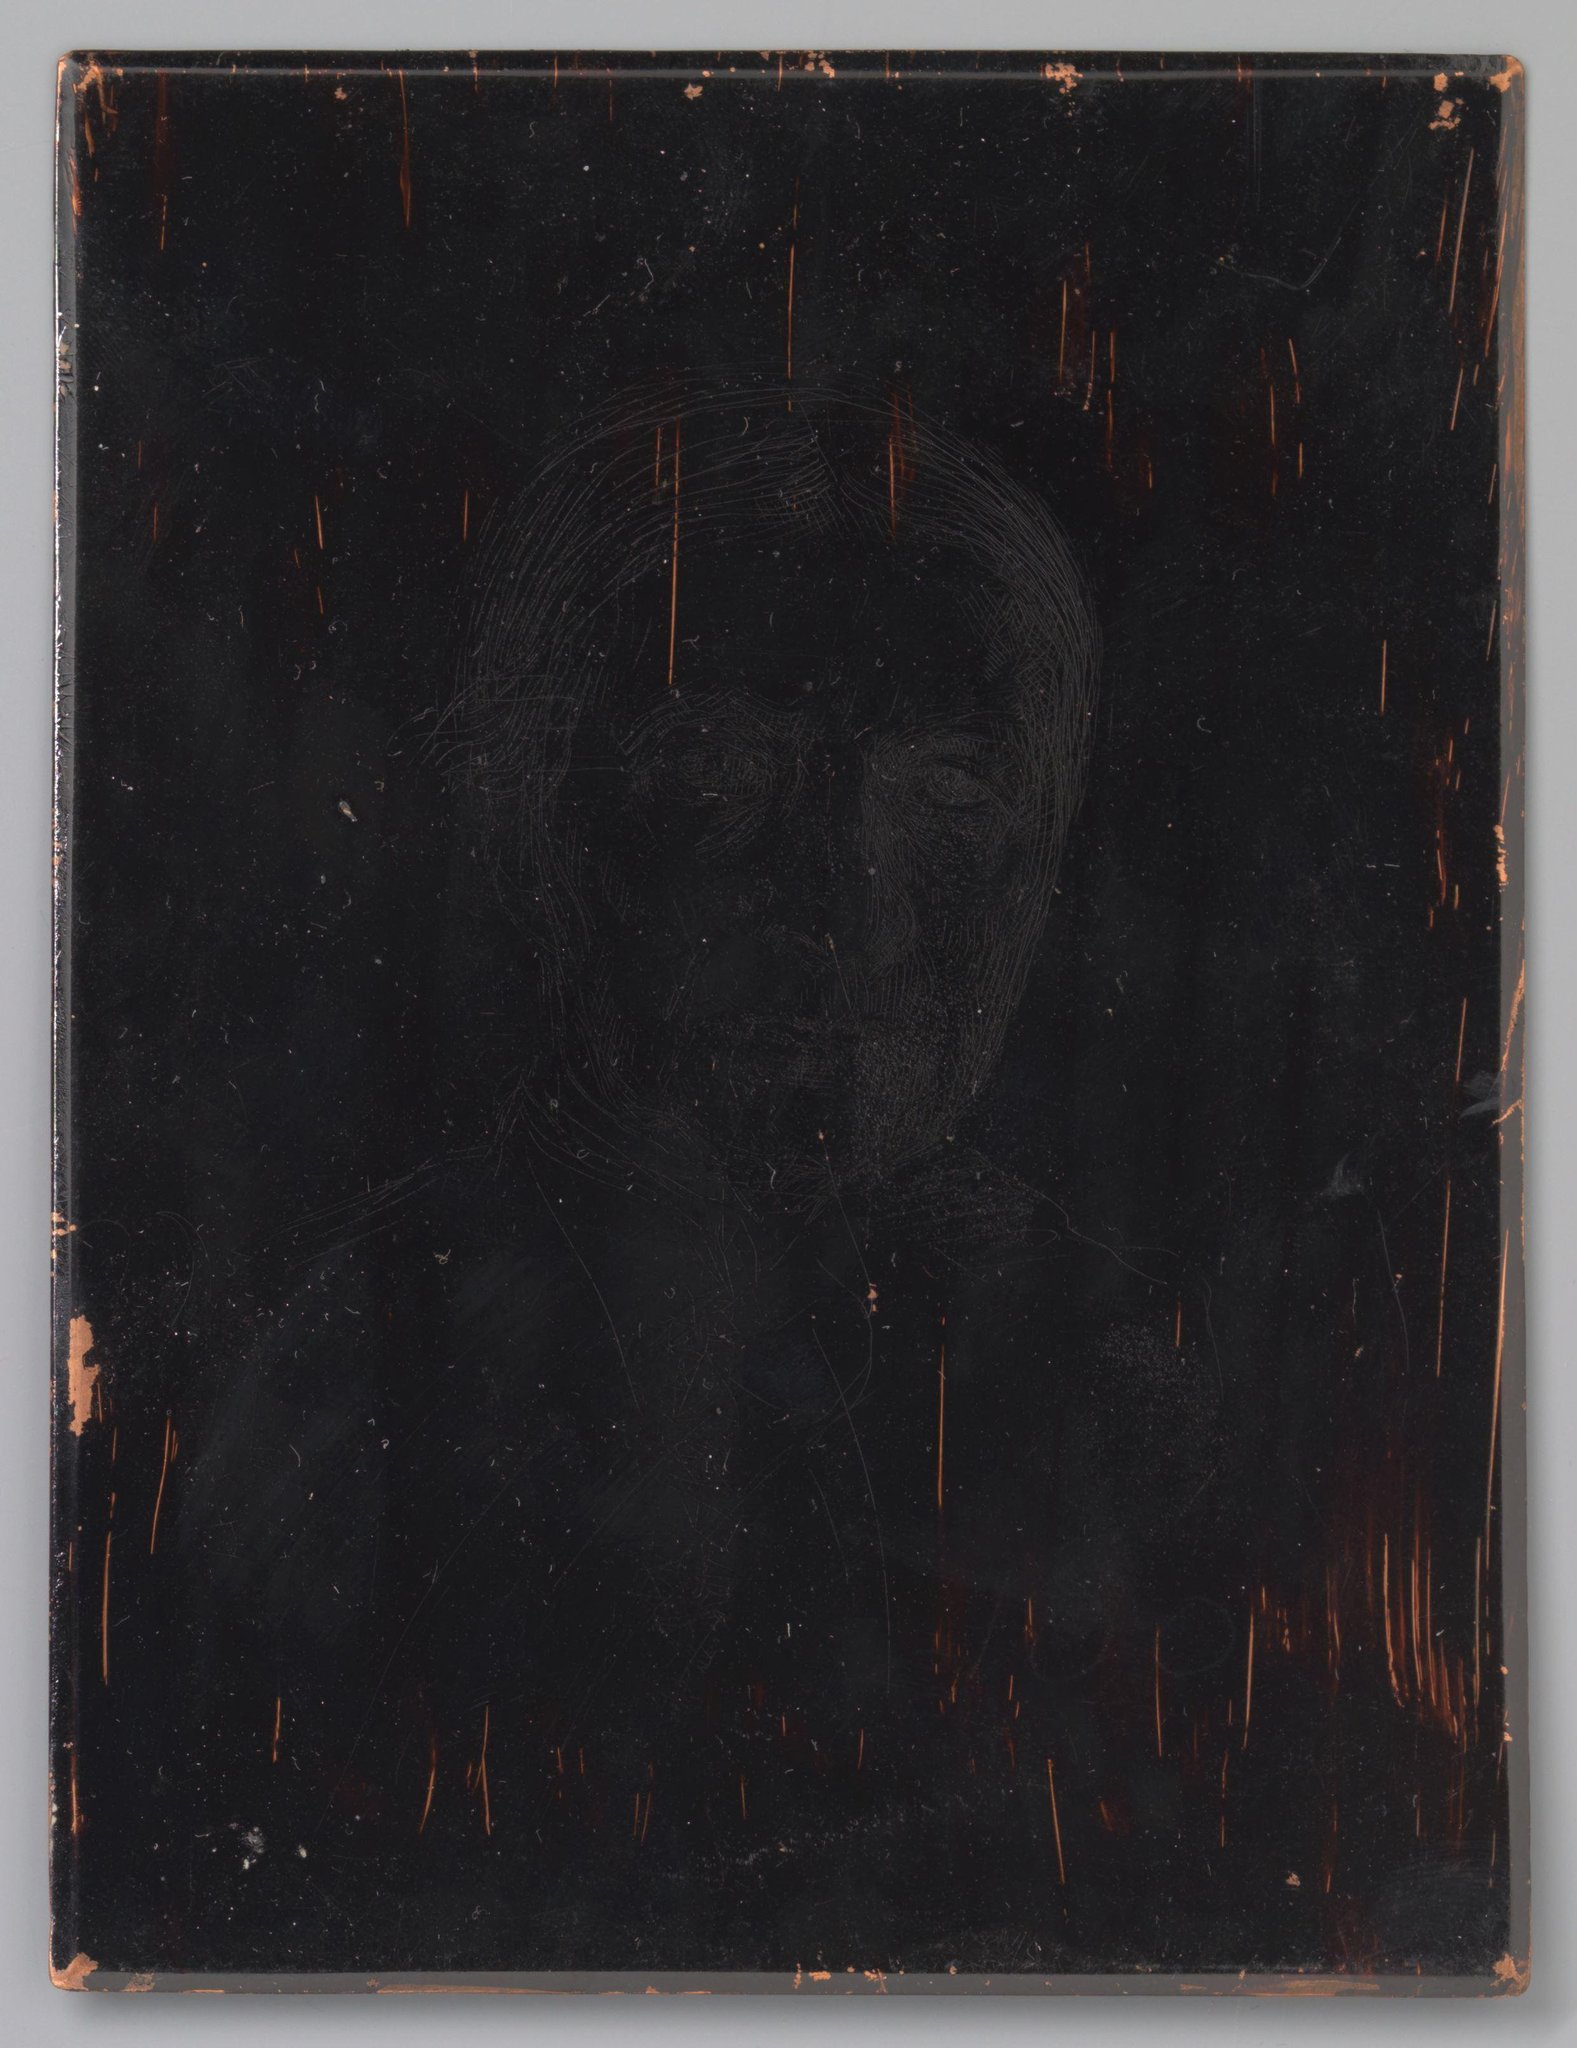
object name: copper plate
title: Portret van mevrouw Anna Cornelia Veth-Giltay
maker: jan veth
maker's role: designer, draughtsman, painter, print maker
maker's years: 1864-1925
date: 1887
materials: copper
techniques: etching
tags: anna cornelia giltay